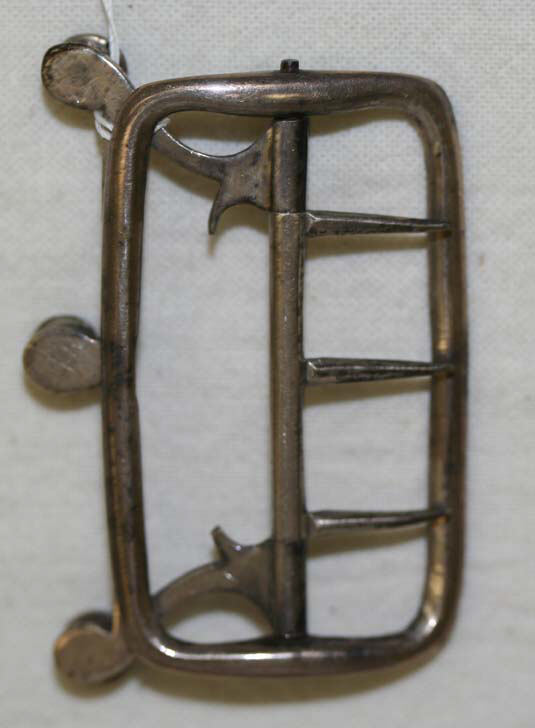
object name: buckle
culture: british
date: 1801-1833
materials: metal